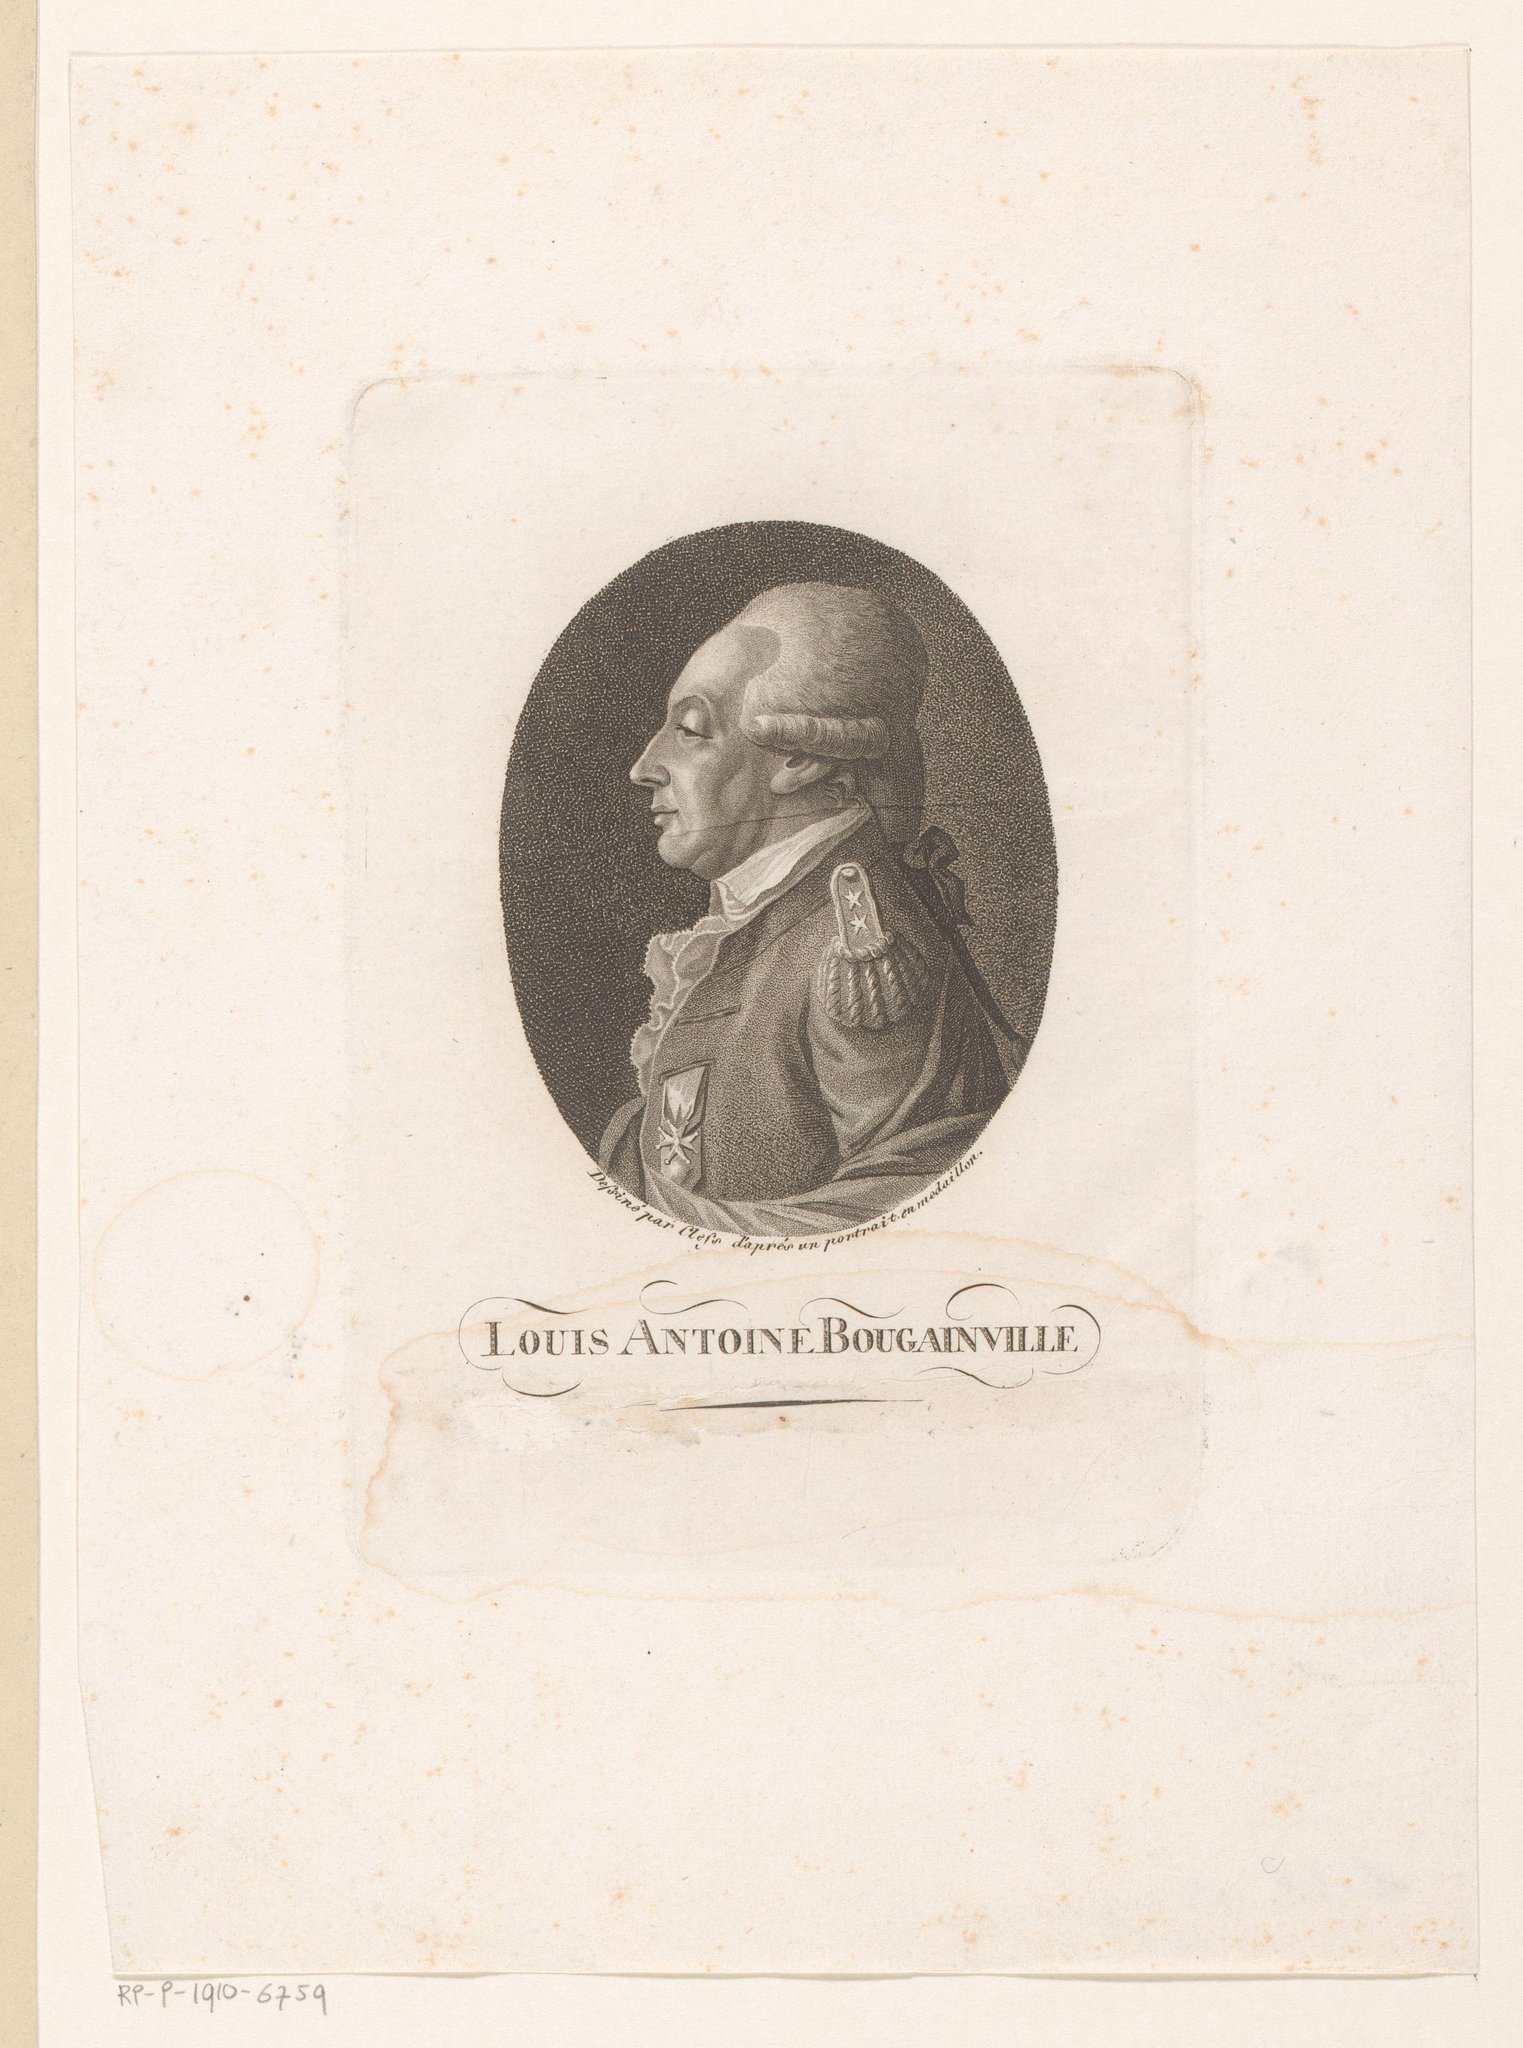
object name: print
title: Portret van Louis-Antoine de Bougainville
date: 1784-1834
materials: paper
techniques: engraving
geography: germany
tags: paris, historical persons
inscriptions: collector's mark: Lugt 2228